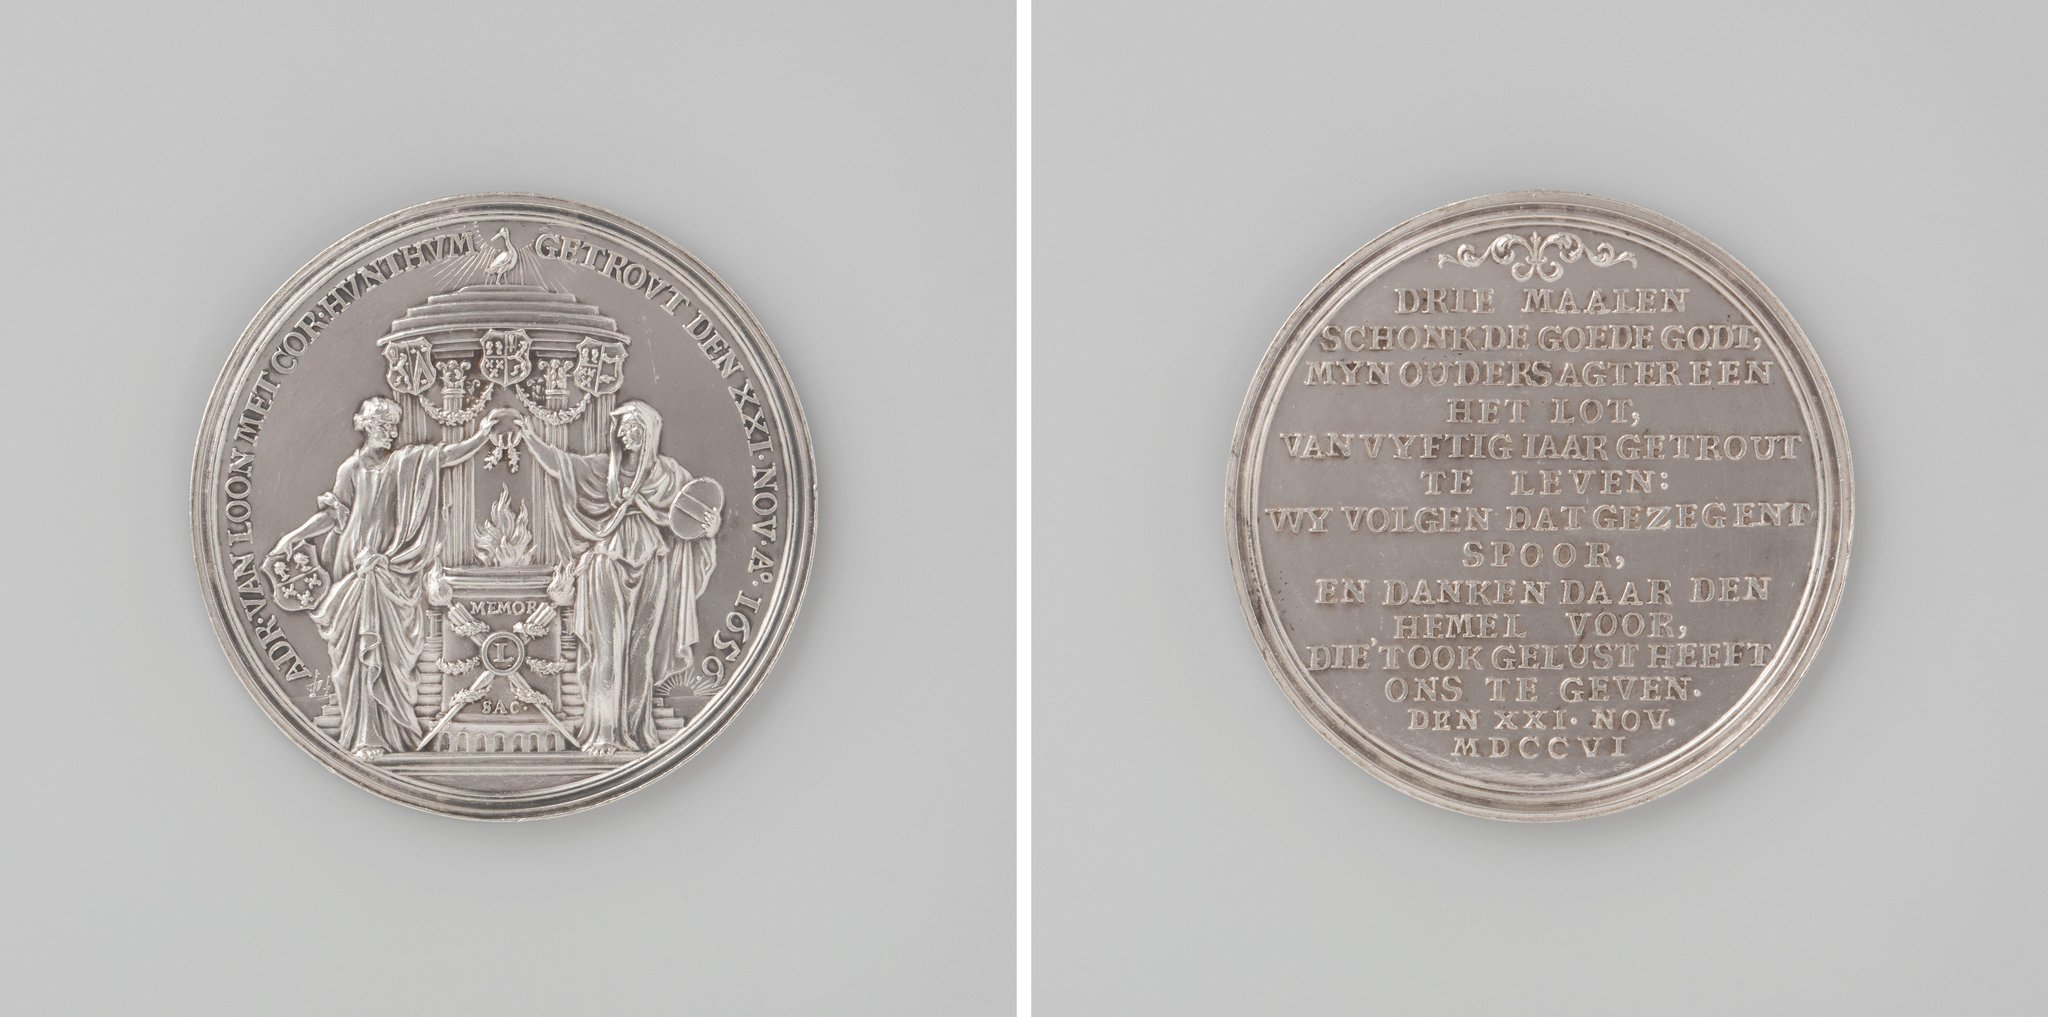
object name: huwelijksjubileumpenning 50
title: Vijftigjarig huwelijk van Adriaan van Loon en Cornelia Hunthum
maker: Anonymous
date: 1706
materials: silver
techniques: striking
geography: netherlands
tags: adriaan van loon, cornelia hunthum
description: Zilveren penning. Voorzijde: man en vrouw met elk een wapenschild houden samen krans vast, staande voor brandend altaar met twee brandende fakkels en medaille met opschrift L binnen omschrift. Keerzijde: opschrift